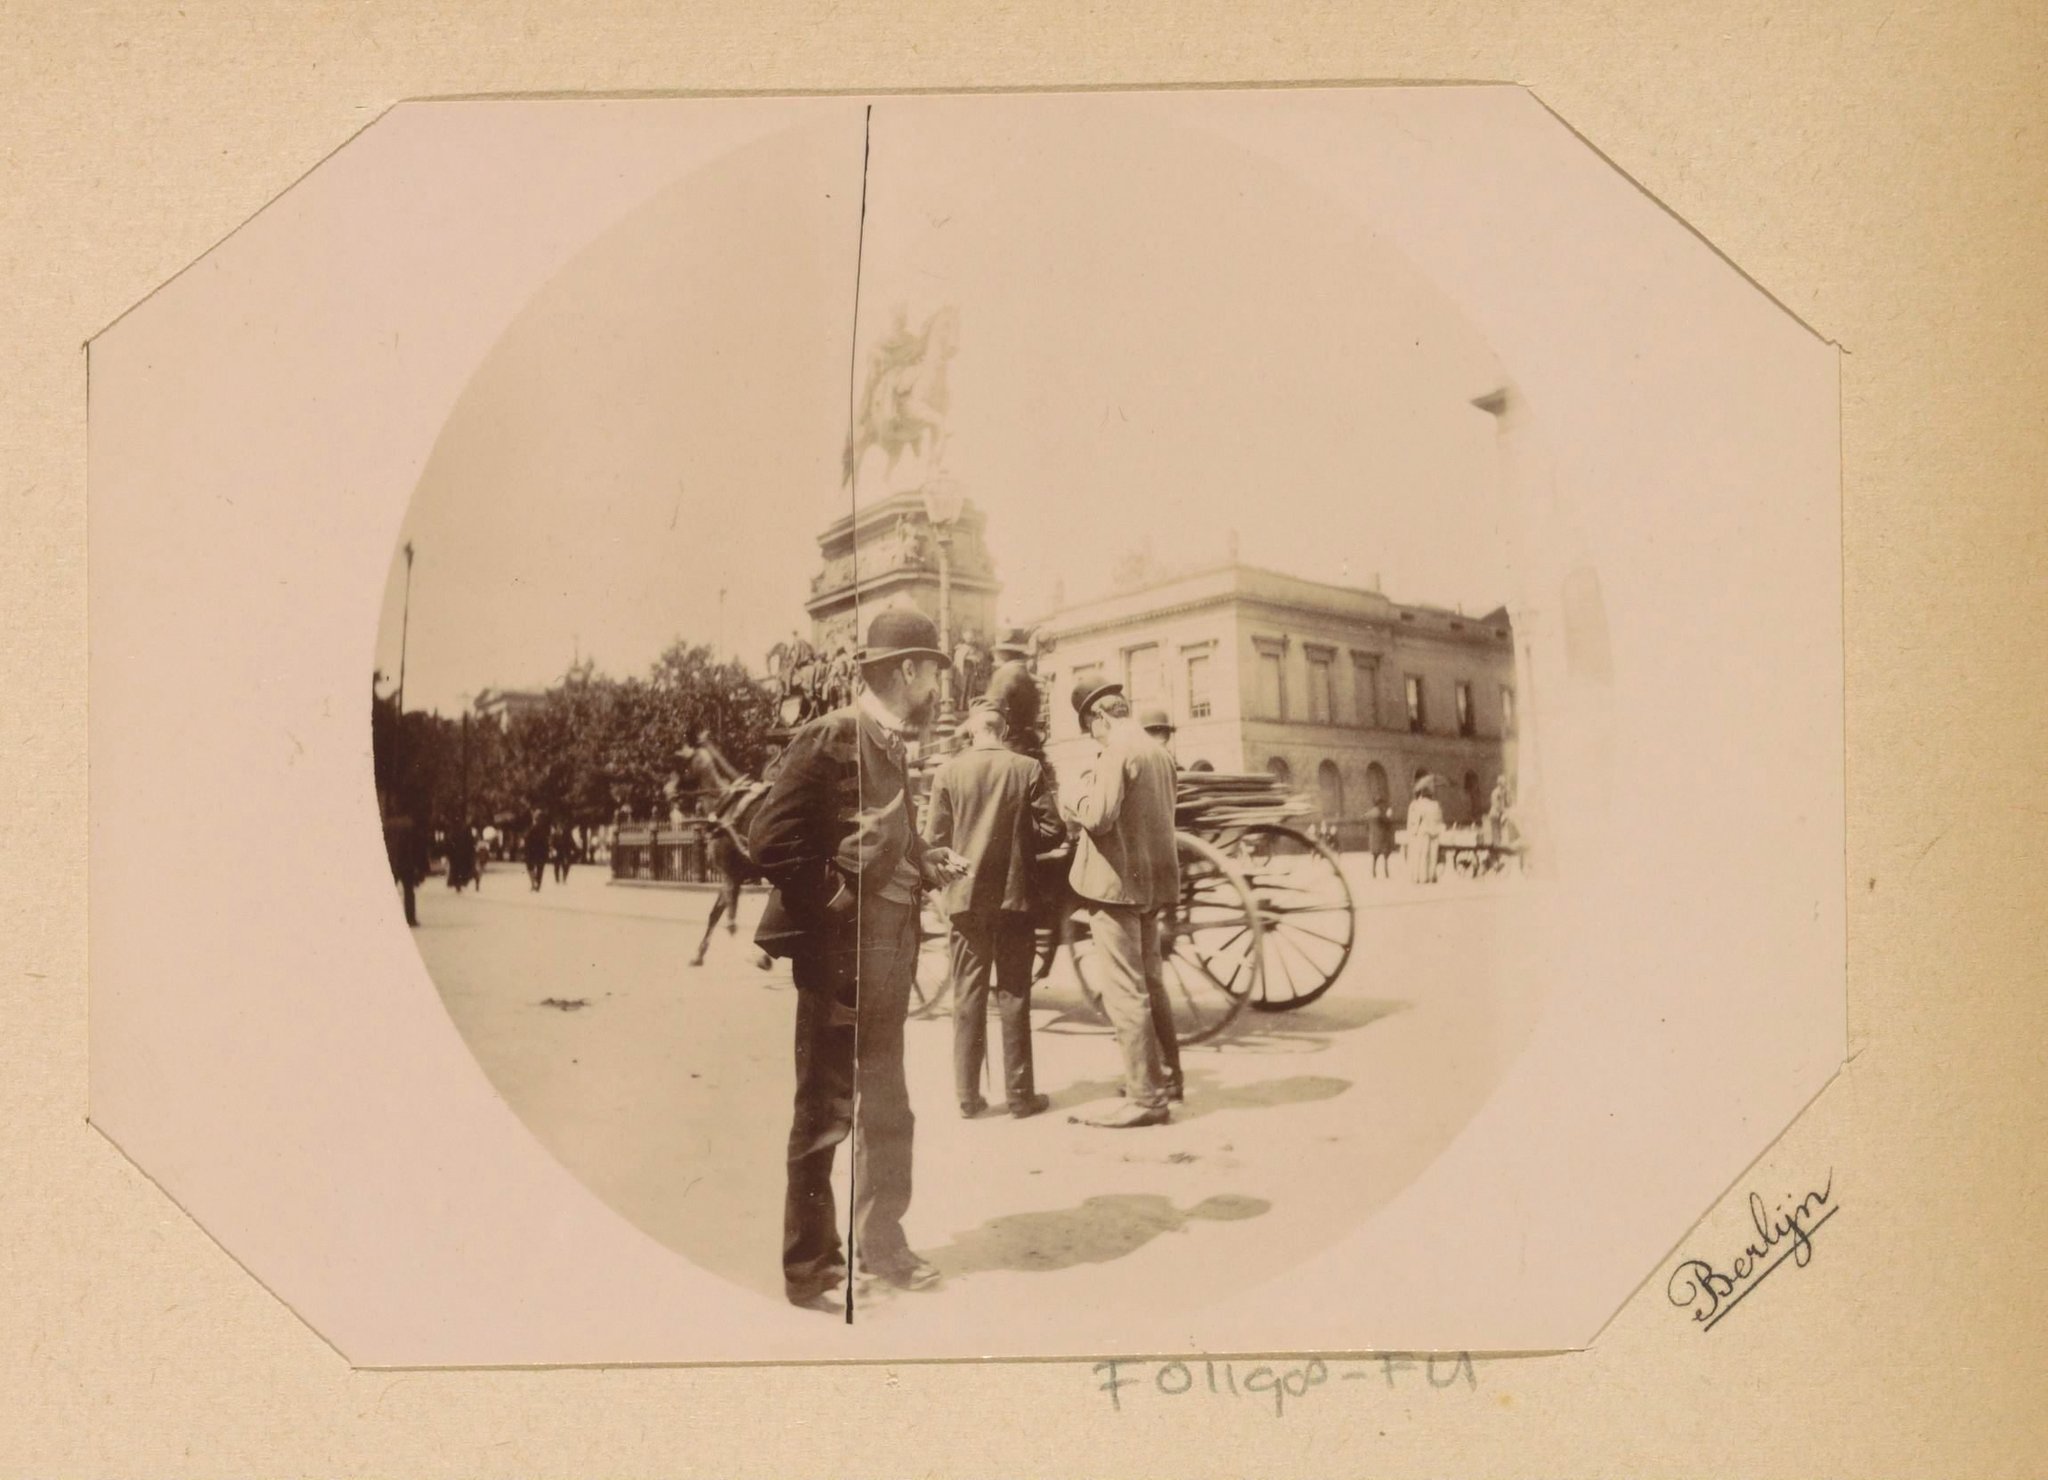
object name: photograph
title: Berlijn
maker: willem frederik piek jr.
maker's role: fotograaf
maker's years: 1874-1954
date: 1889-1893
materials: paper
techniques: gelatin silver print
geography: berlin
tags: monument, statue